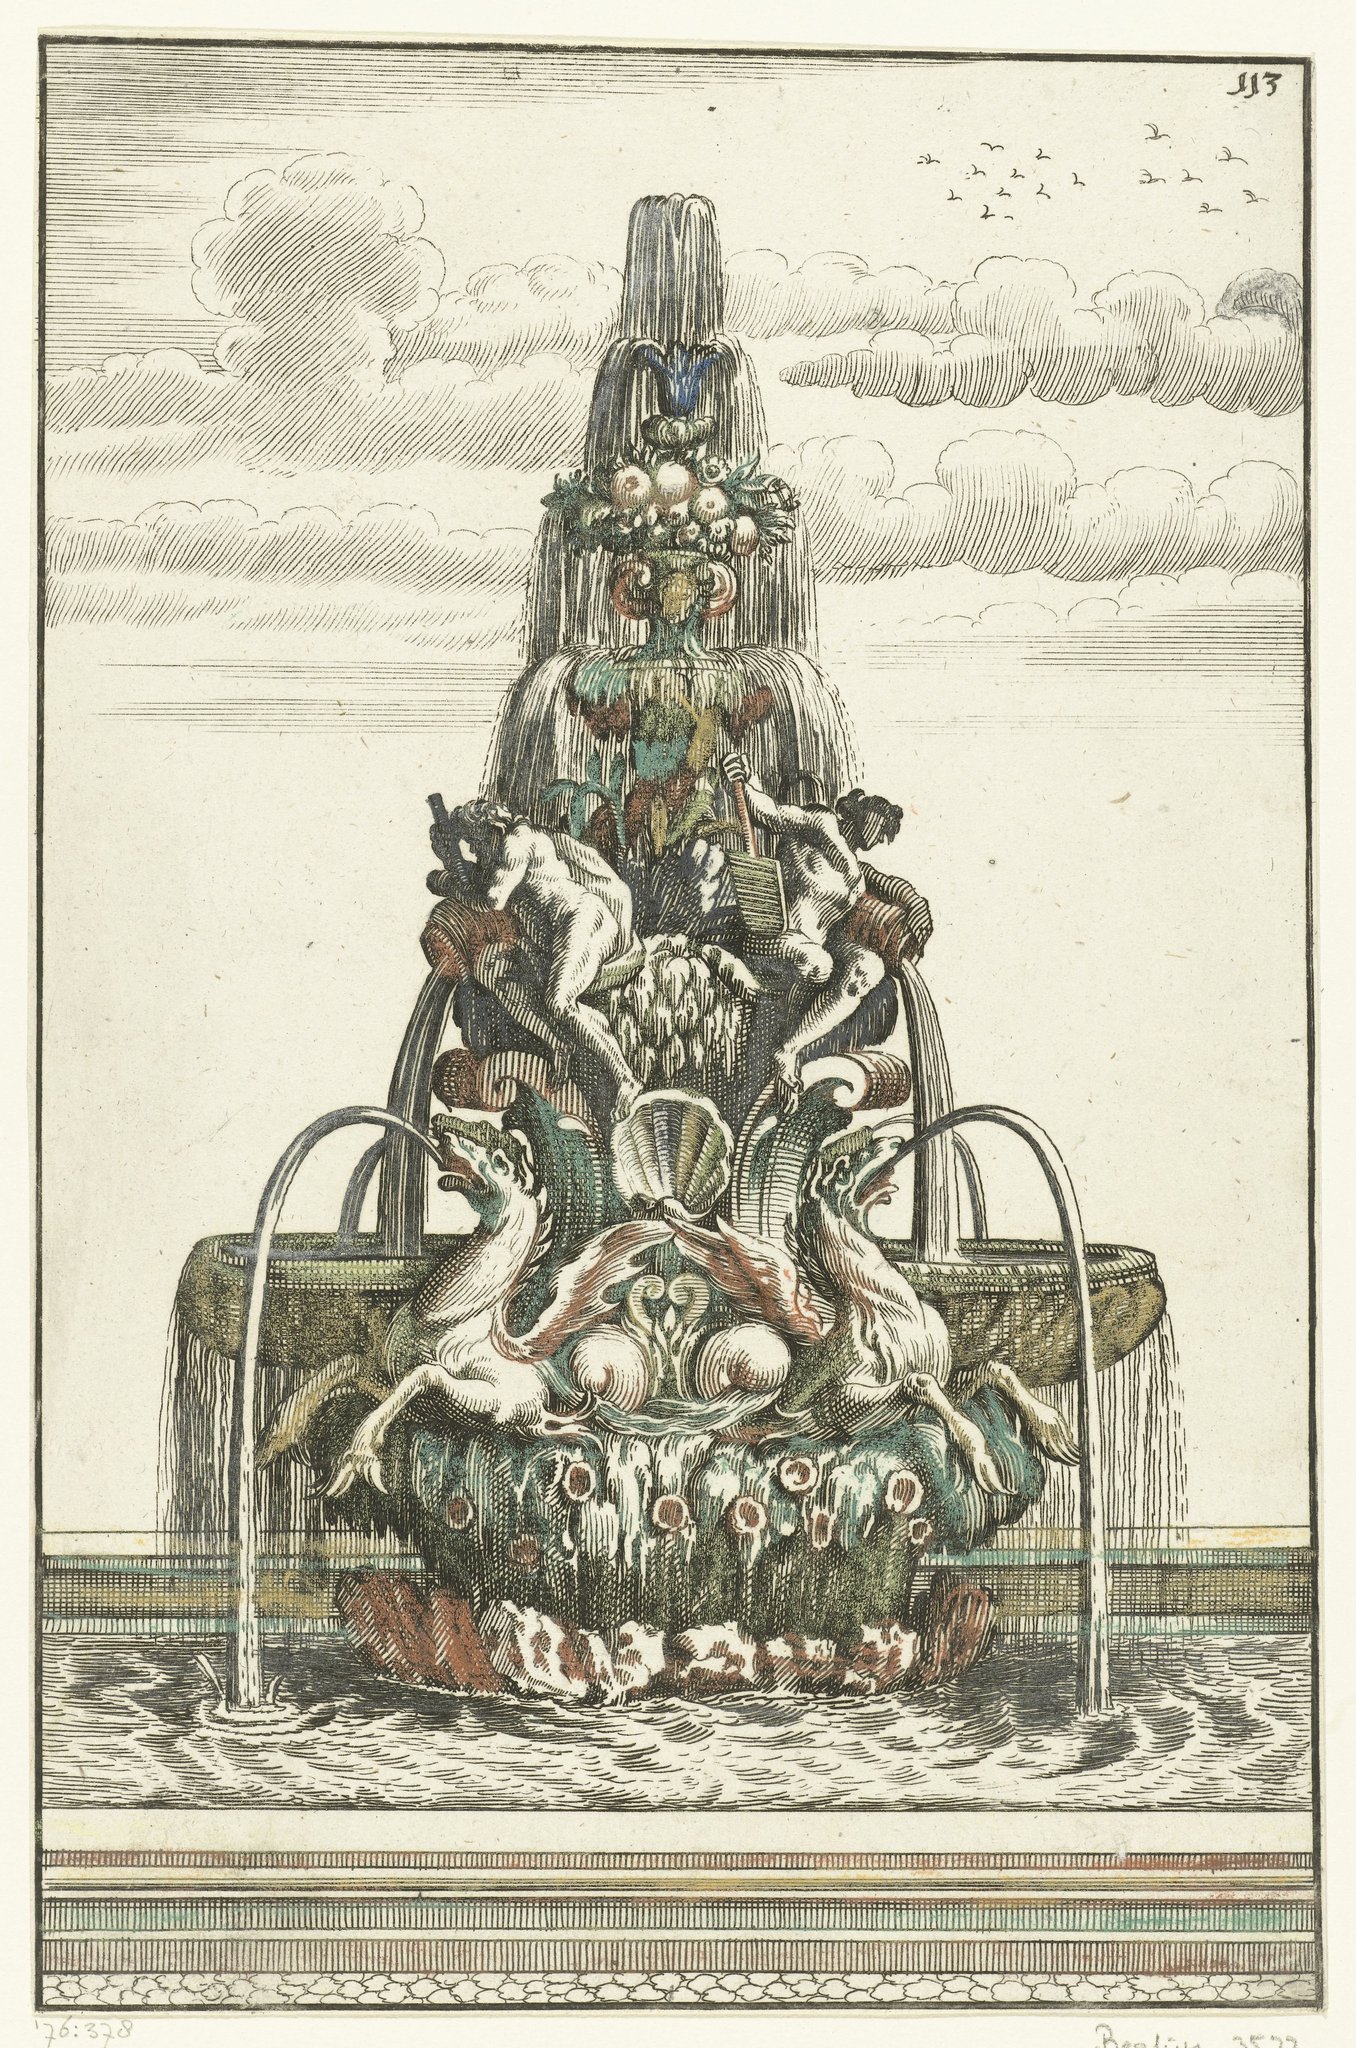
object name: ornament print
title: Fontein in de vorm van een piramide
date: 1664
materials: paper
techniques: etching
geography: germany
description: De fontein is gedecoreerd met gevleugelde zeepaarden, zeegoden, schelpen, vazen met bloemen en fruit. Blad 113 uit deel III van een serie bestaande uit 226 bladen, verdeeld over vier boeken, elk met een eigen titelblad.